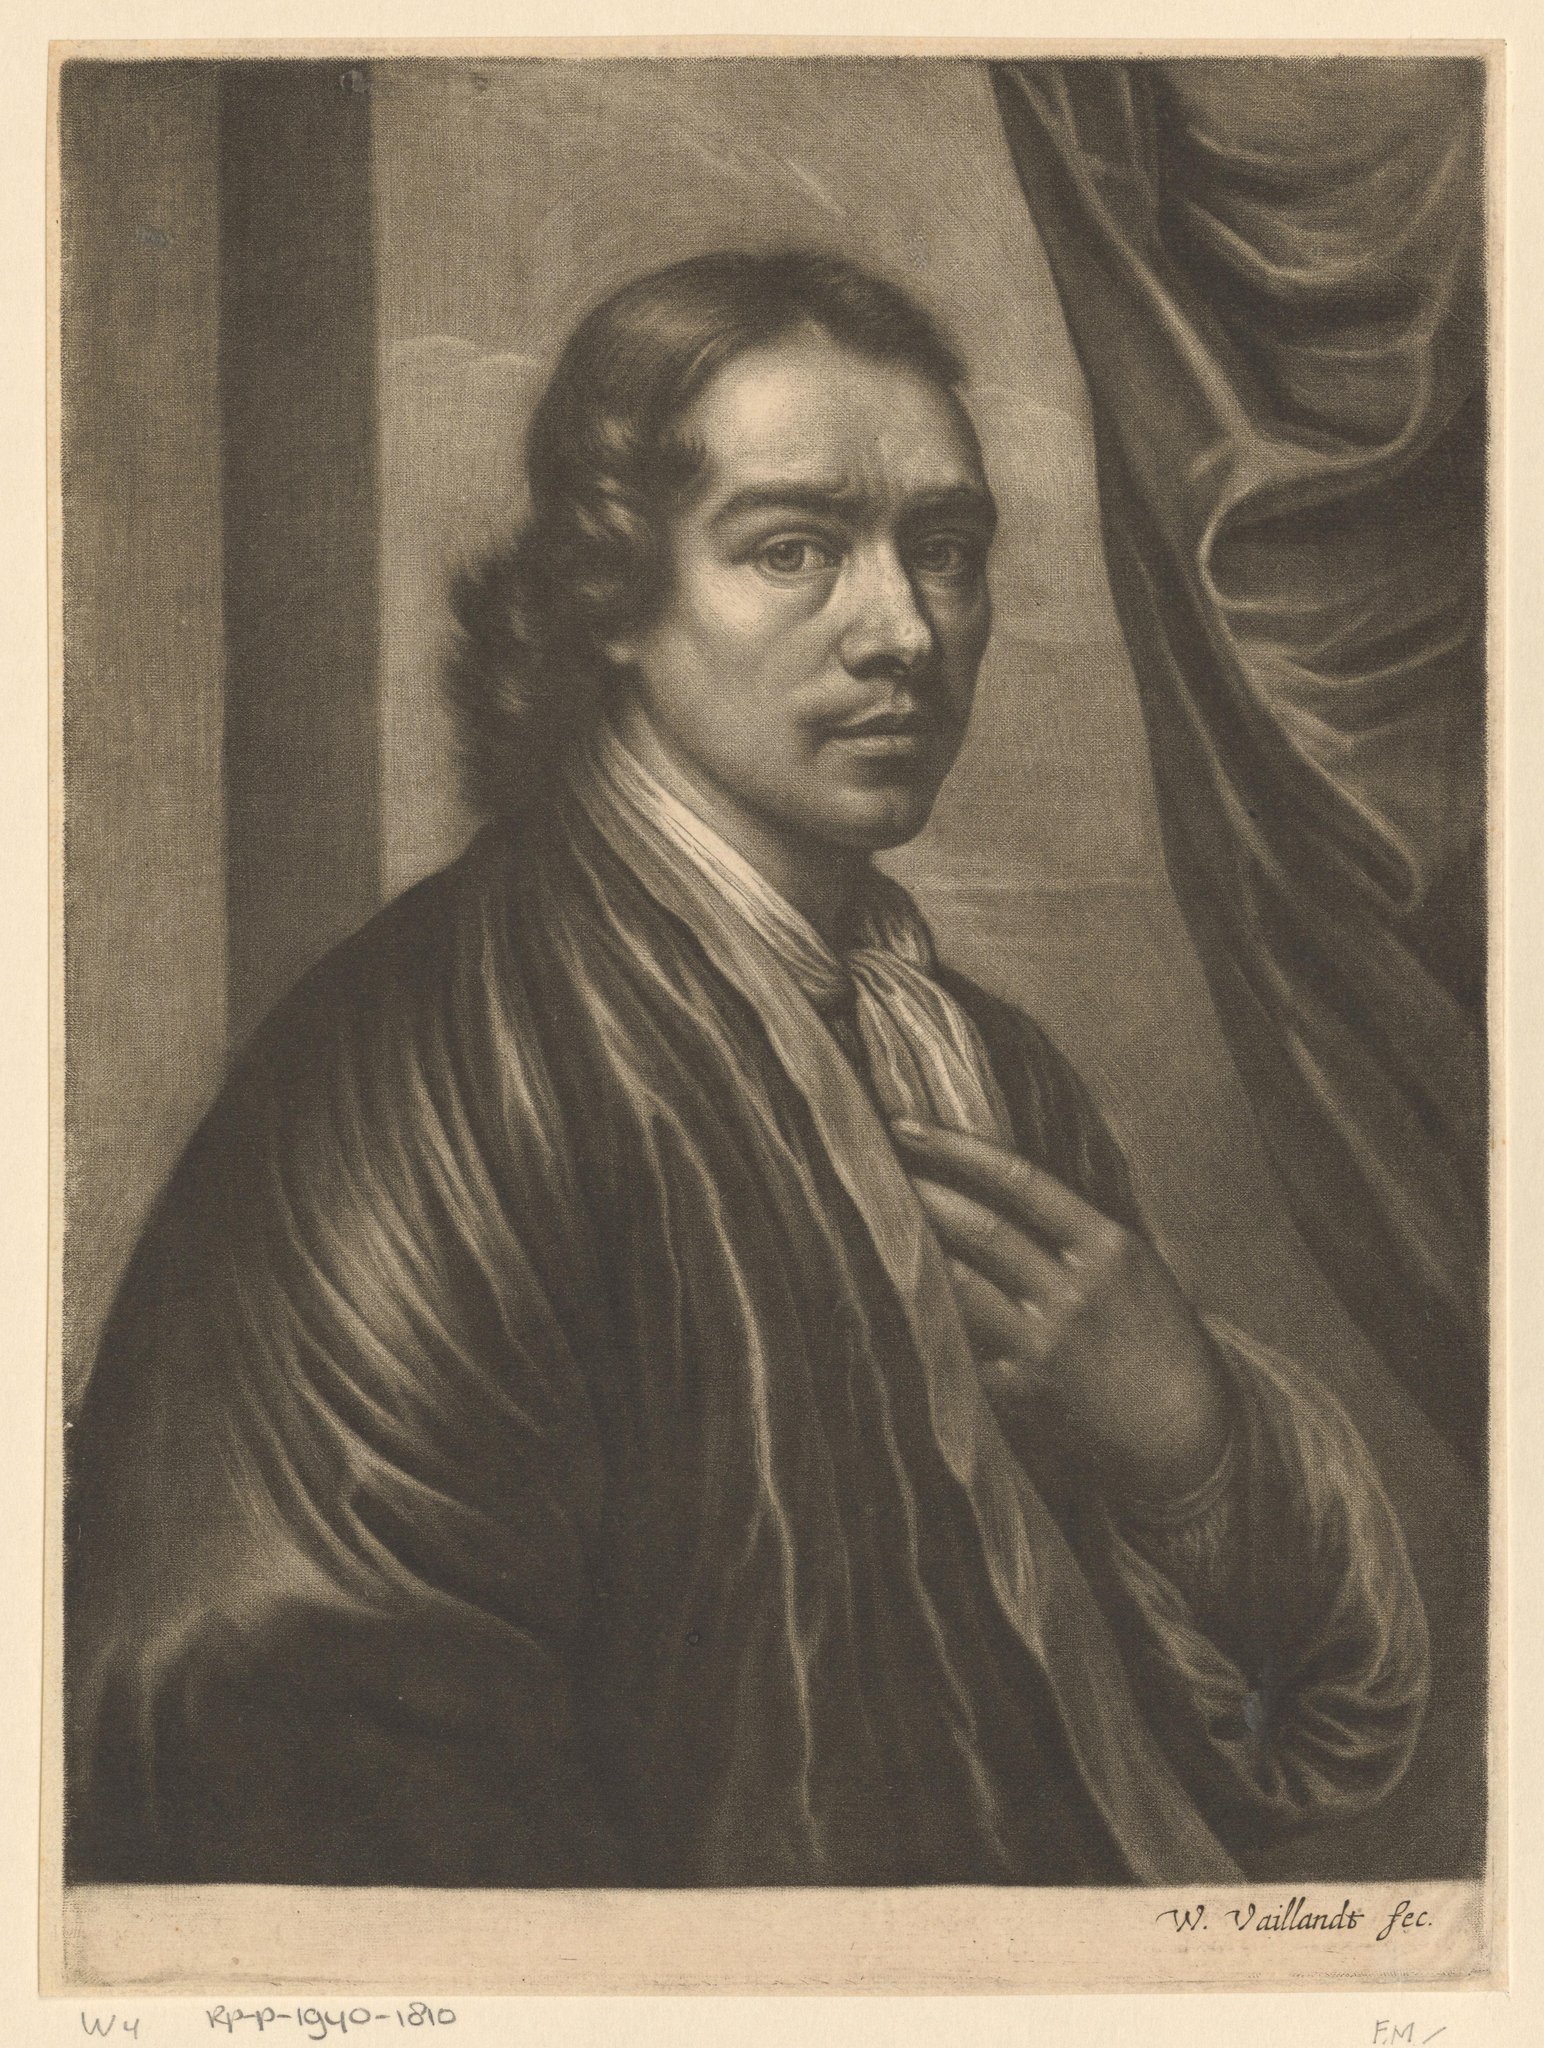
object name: print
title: Zelfportret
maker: wallerant vaillant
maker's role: draughtsman, painter, print maker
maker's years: 1623-1677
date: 1671-1677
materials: paper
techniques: mezzotint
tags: amsterdam, painter, print maker, draughtsman, wallerant vaillant, historical persons, portrait, self-portrait of graphic artist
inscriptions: collector's mark: Lugt 1760, collector's mark: Lugt 2228